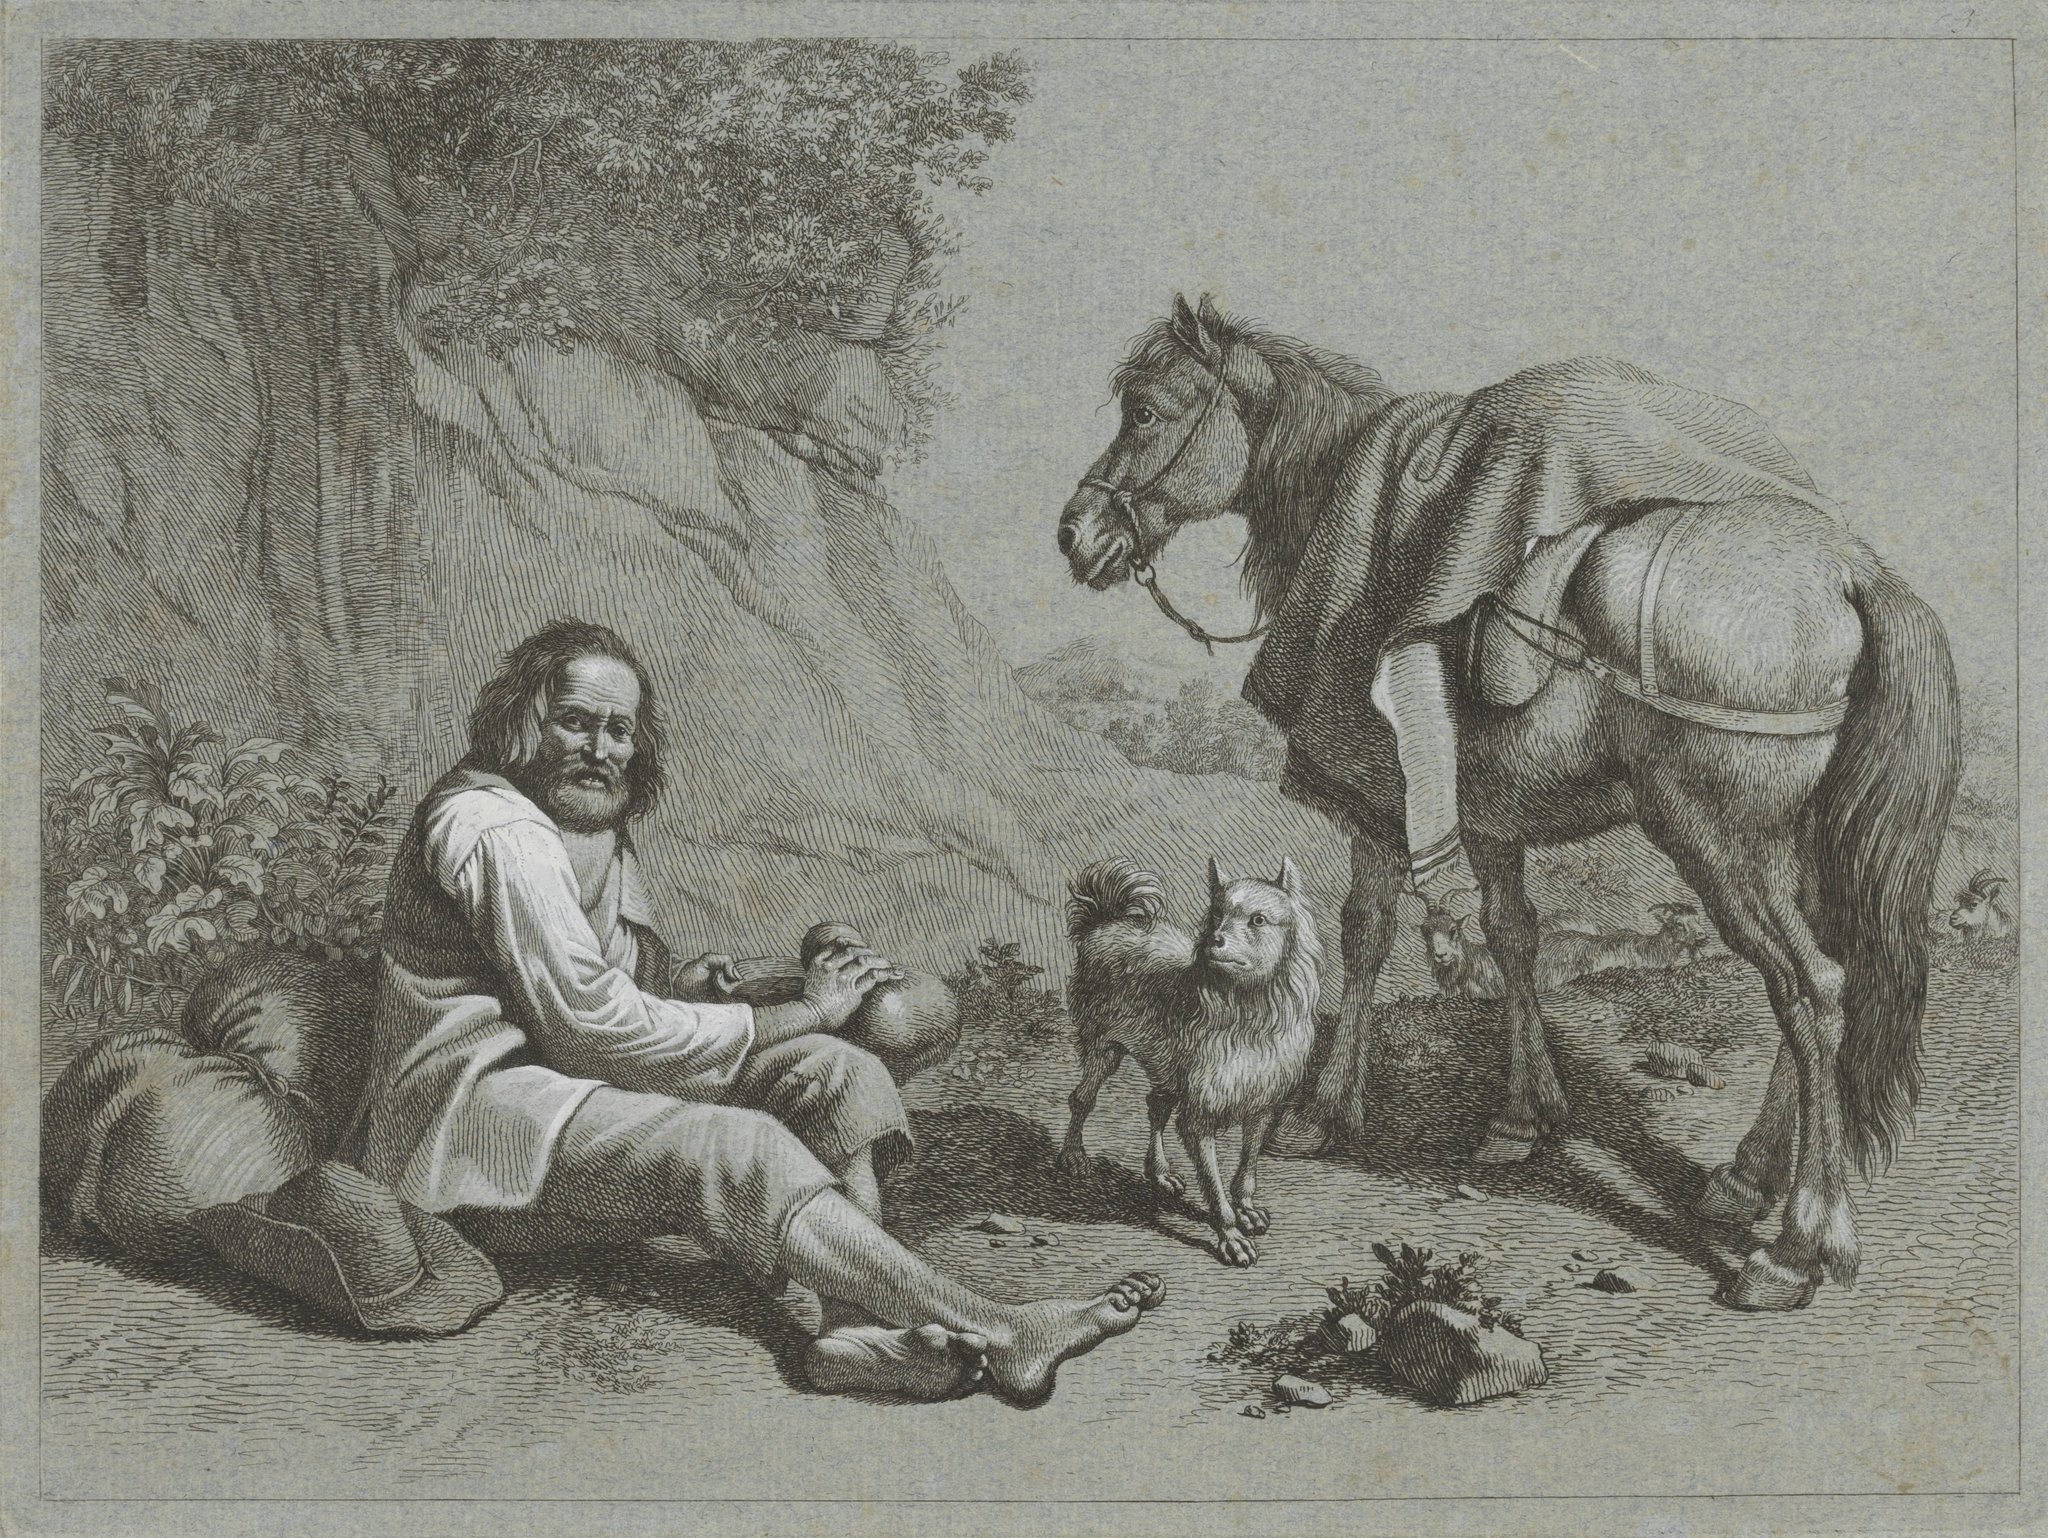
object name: print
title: Herdertaferelen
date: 1763-1764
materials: paper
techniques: etching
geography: exeter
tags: herding, herdsman, herdswoman, shepherd, shepherdess, cowherd, etc., (traveller) resting in the open air, horse, herd, flock, dog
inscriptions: collector's mark: Lugt 240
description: Een herder zittend in een landschap met een paard en een hond. Op de achtergrond een kudde geiten.